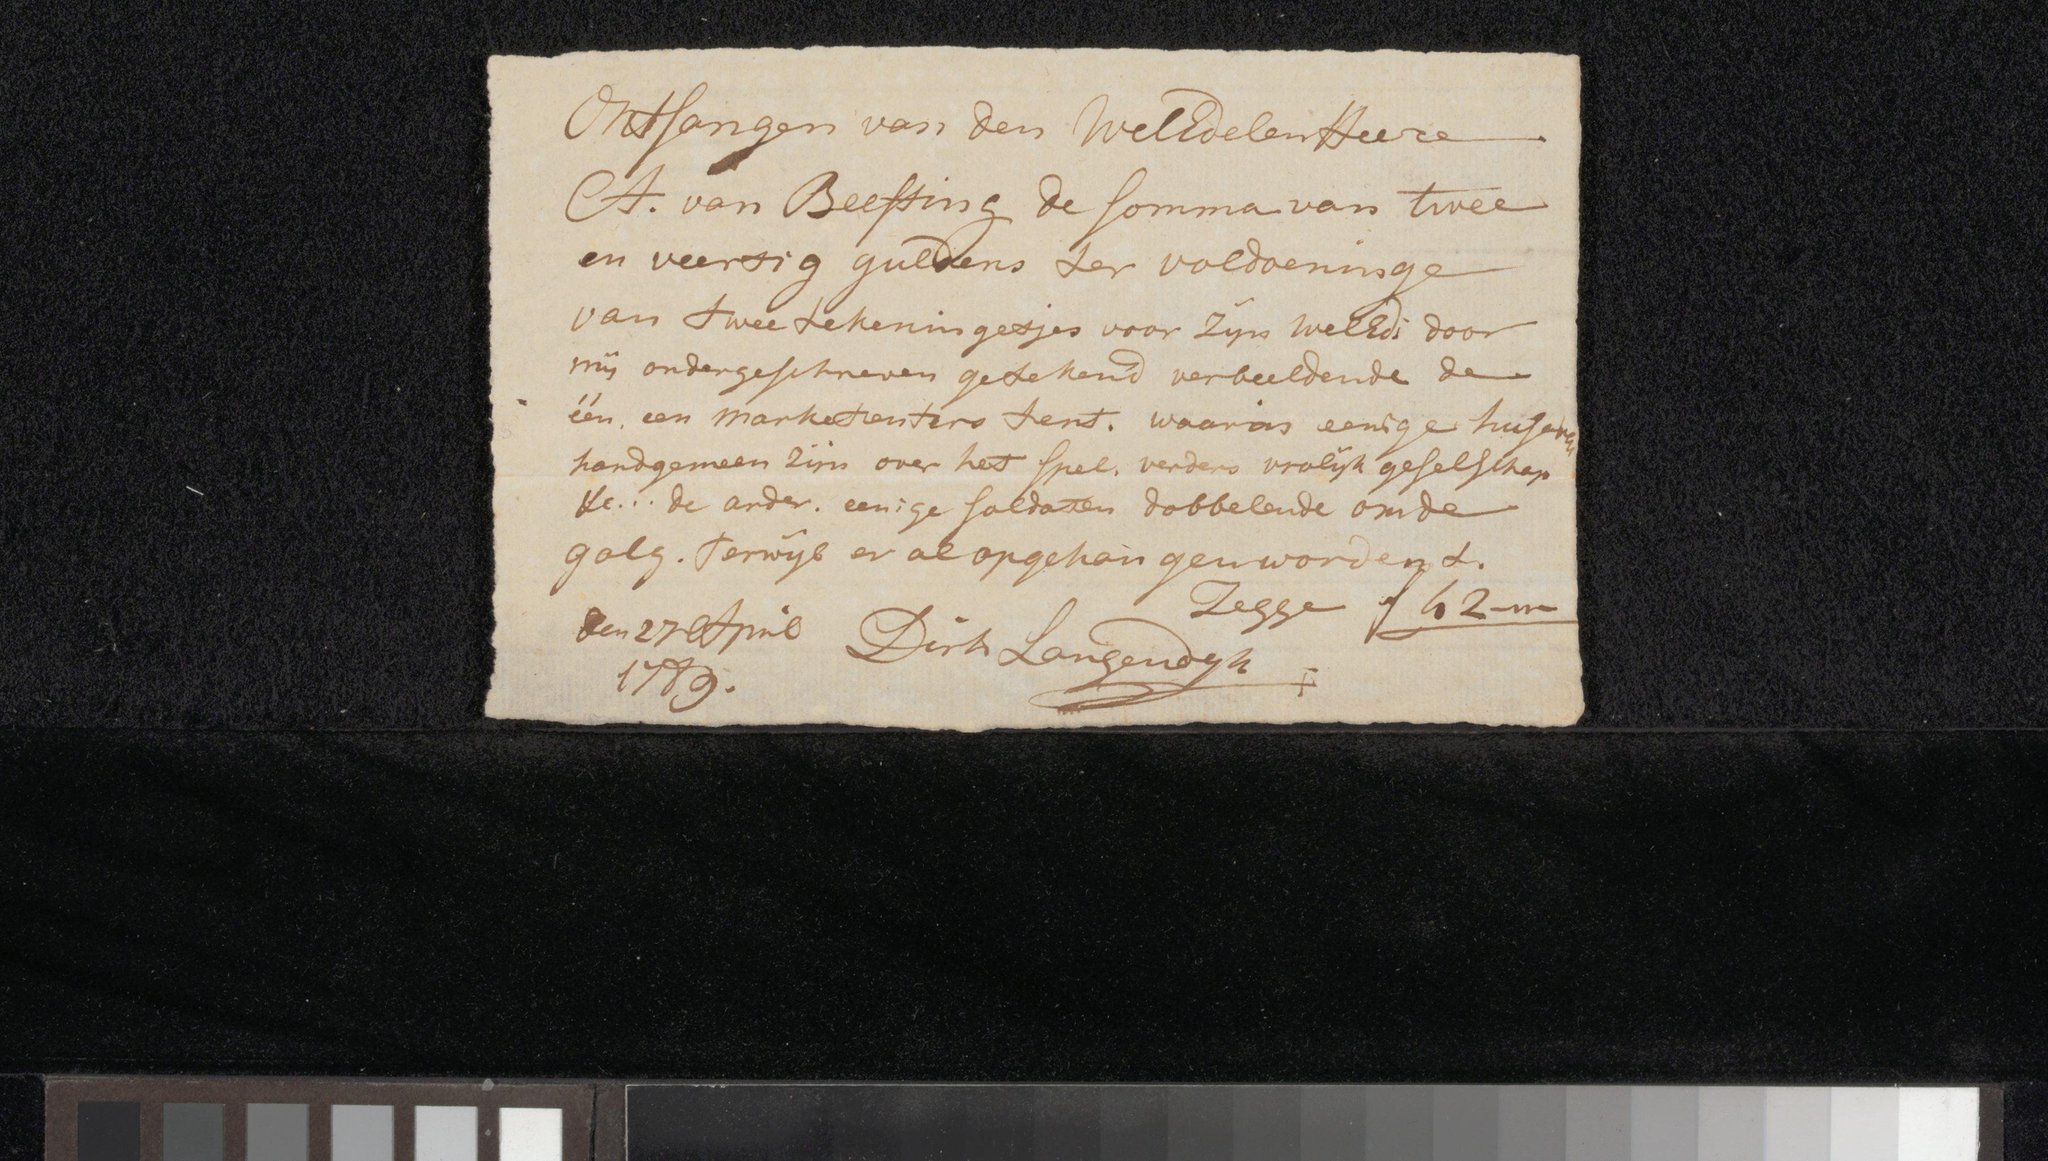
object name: ontvangstbewijs, kwitantie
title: Kwitantie voor Aernout van Beeftingh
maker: dirk langendijk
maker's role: draughtsman, painter, print maker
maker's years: 1748-1805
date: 1789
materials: ink, paper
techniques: pen, writing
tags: drawing, money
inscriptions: collector's mark: Lugt 2166, collector's mark: Lugt 2233, watermark